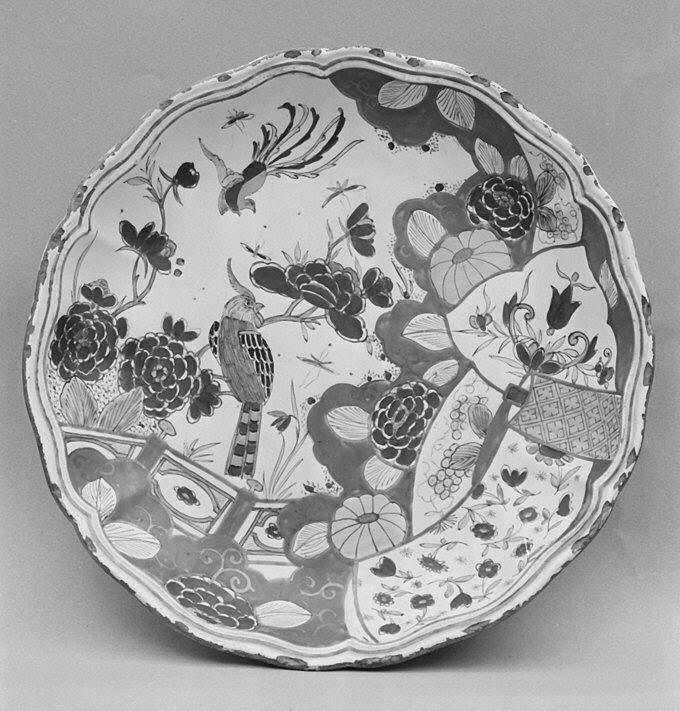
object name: dish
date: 1801-1900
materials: earthenware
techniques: glazing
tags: birds,flowers